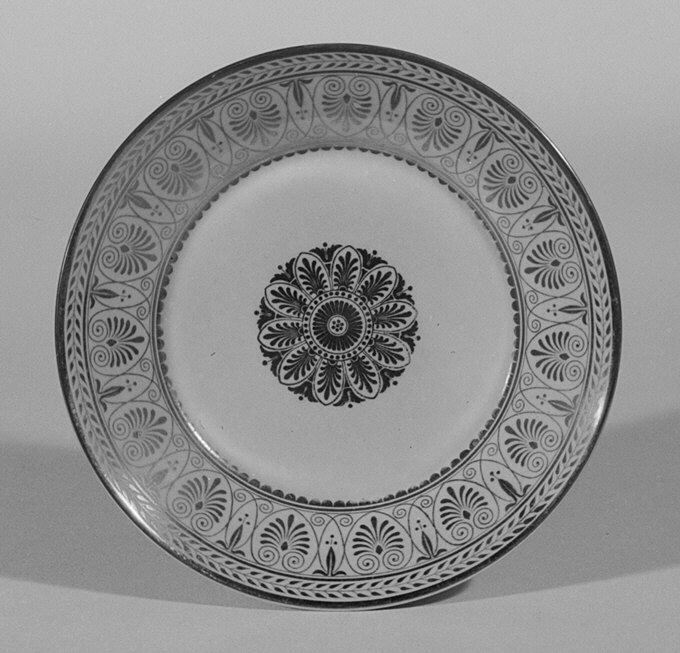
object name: saucer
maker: sèvres manufactory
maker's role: manufactory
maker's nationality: french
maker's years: 1740-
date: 1839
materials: hard paste porcelain